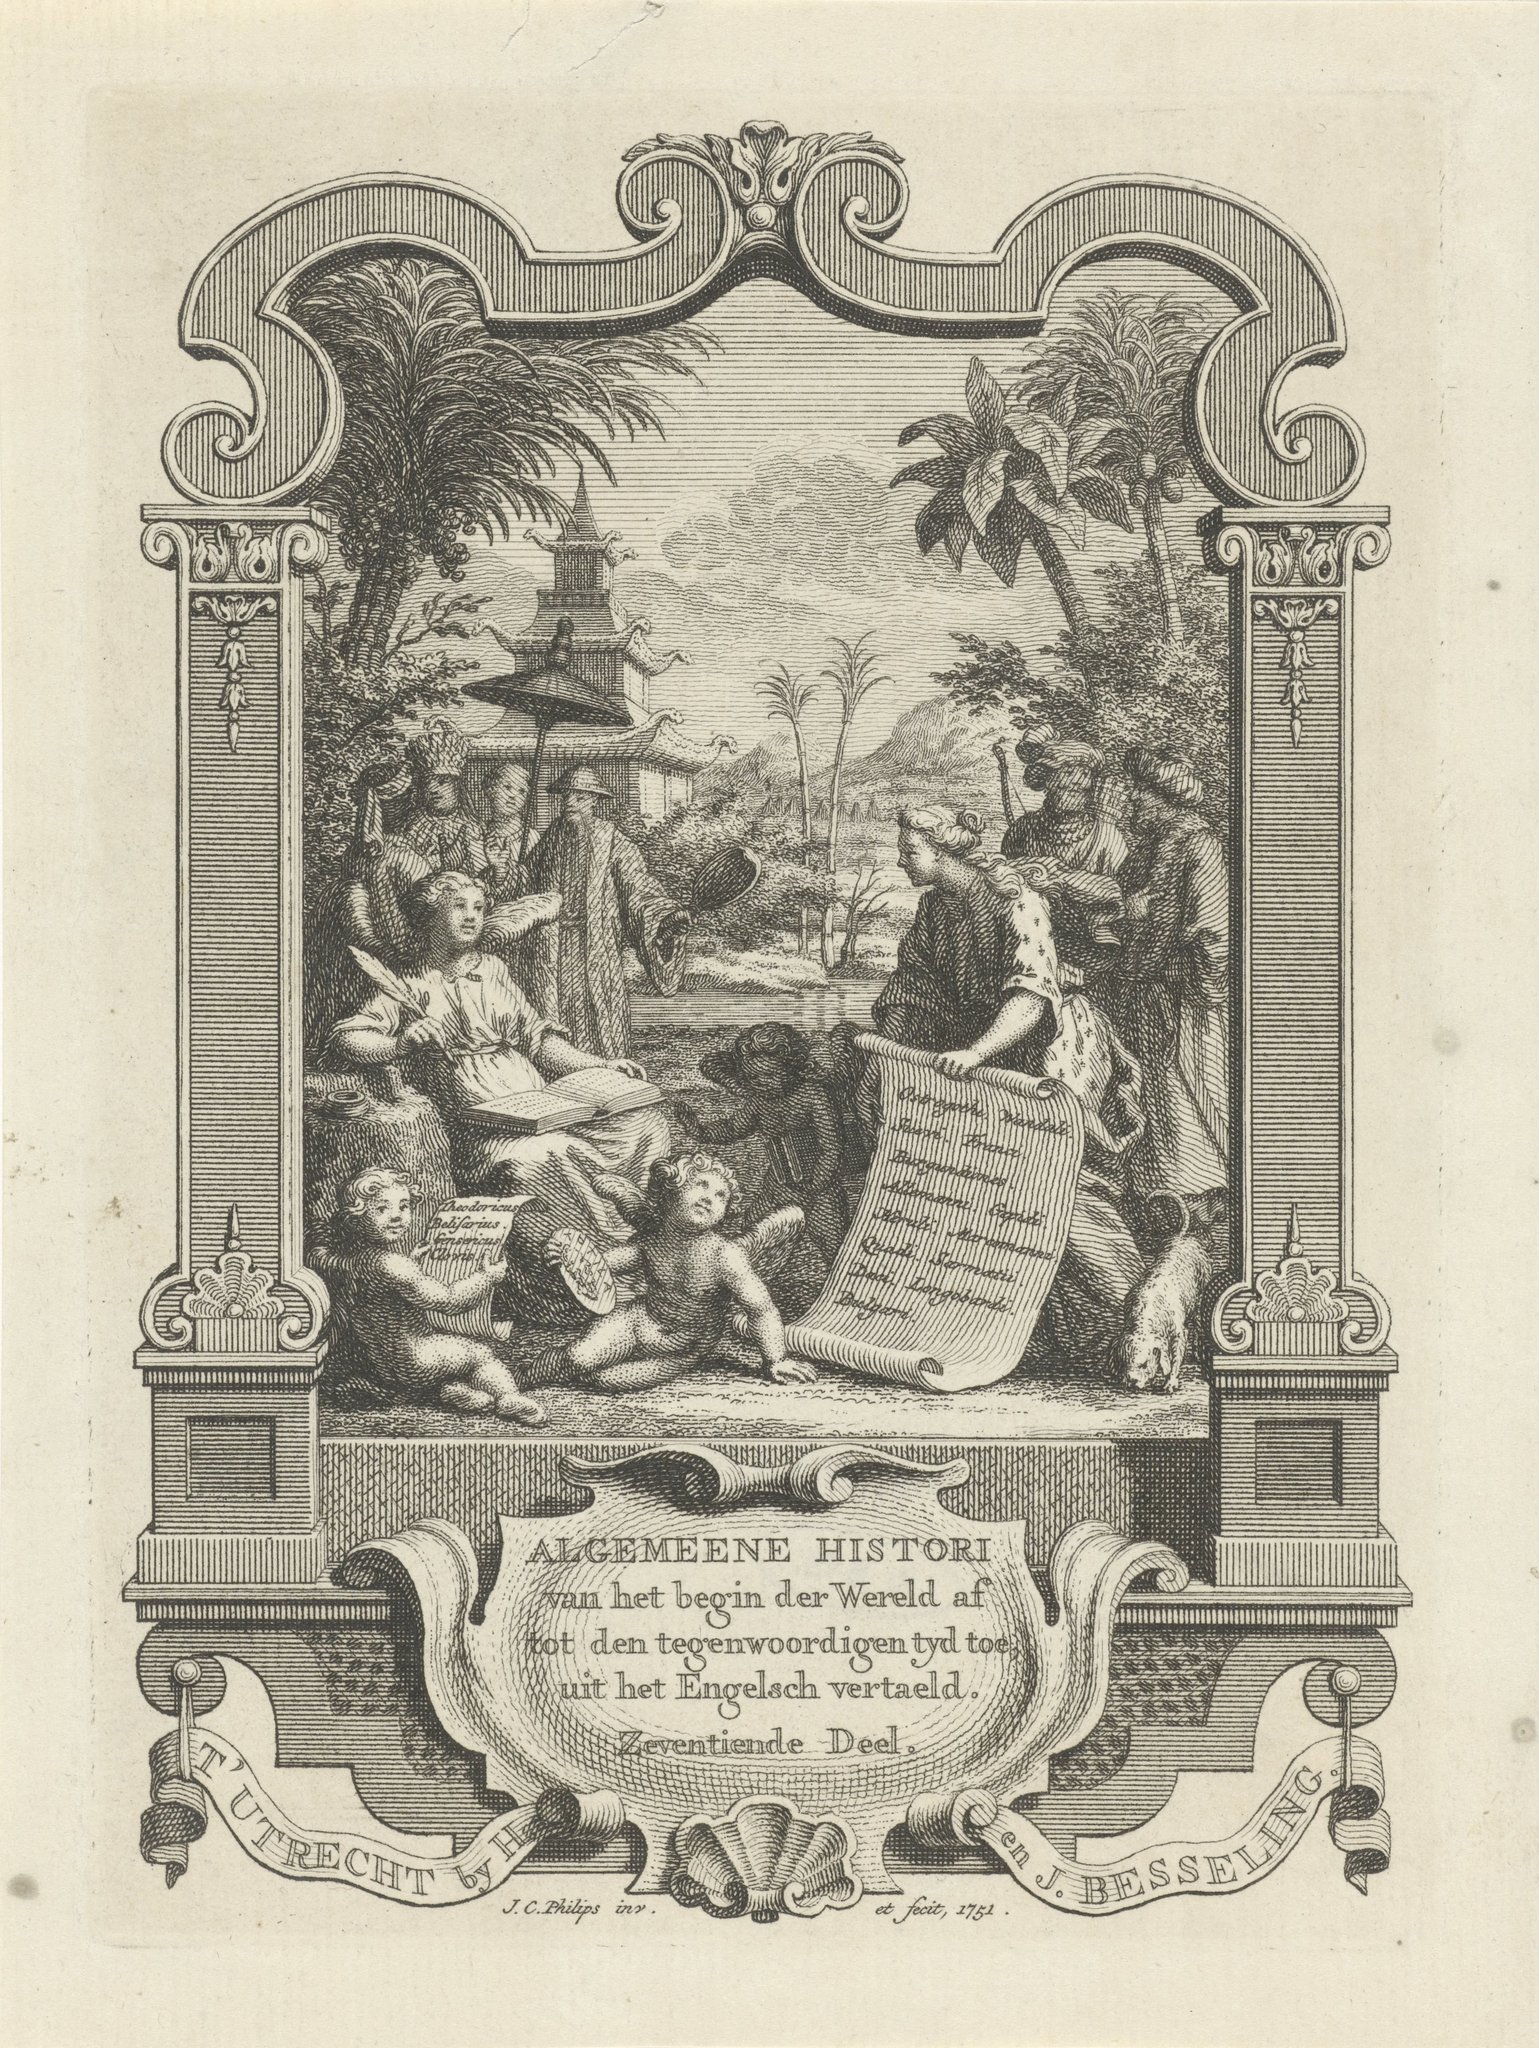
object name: titelblad, titelpagina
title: Titelpagina voor: K. Westerbaen, Algemeene Histori, 1751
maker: jan caspar philips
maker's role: draughtsman, print maker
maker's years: 1700-1775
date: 1751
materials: paper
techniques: engraving, etching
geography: utrecht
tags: asiatic races and peoples, chinese, africans, 'historia'; 'historia' (ripa), native peoples of the americas, white races and peoples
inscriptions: collector's mark: Lugt 2228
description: Geschiedenis schrijft in haar boek. Een vrouw toont haar een vel waarop de in het boek geschreven volken staan opgesomd. Bij haar zitten putti, één met in de hand een medaillon met het portret van Totila, koning van de Ostrogoten. Op de achtergrond mensen uit verschillende werelddelen.